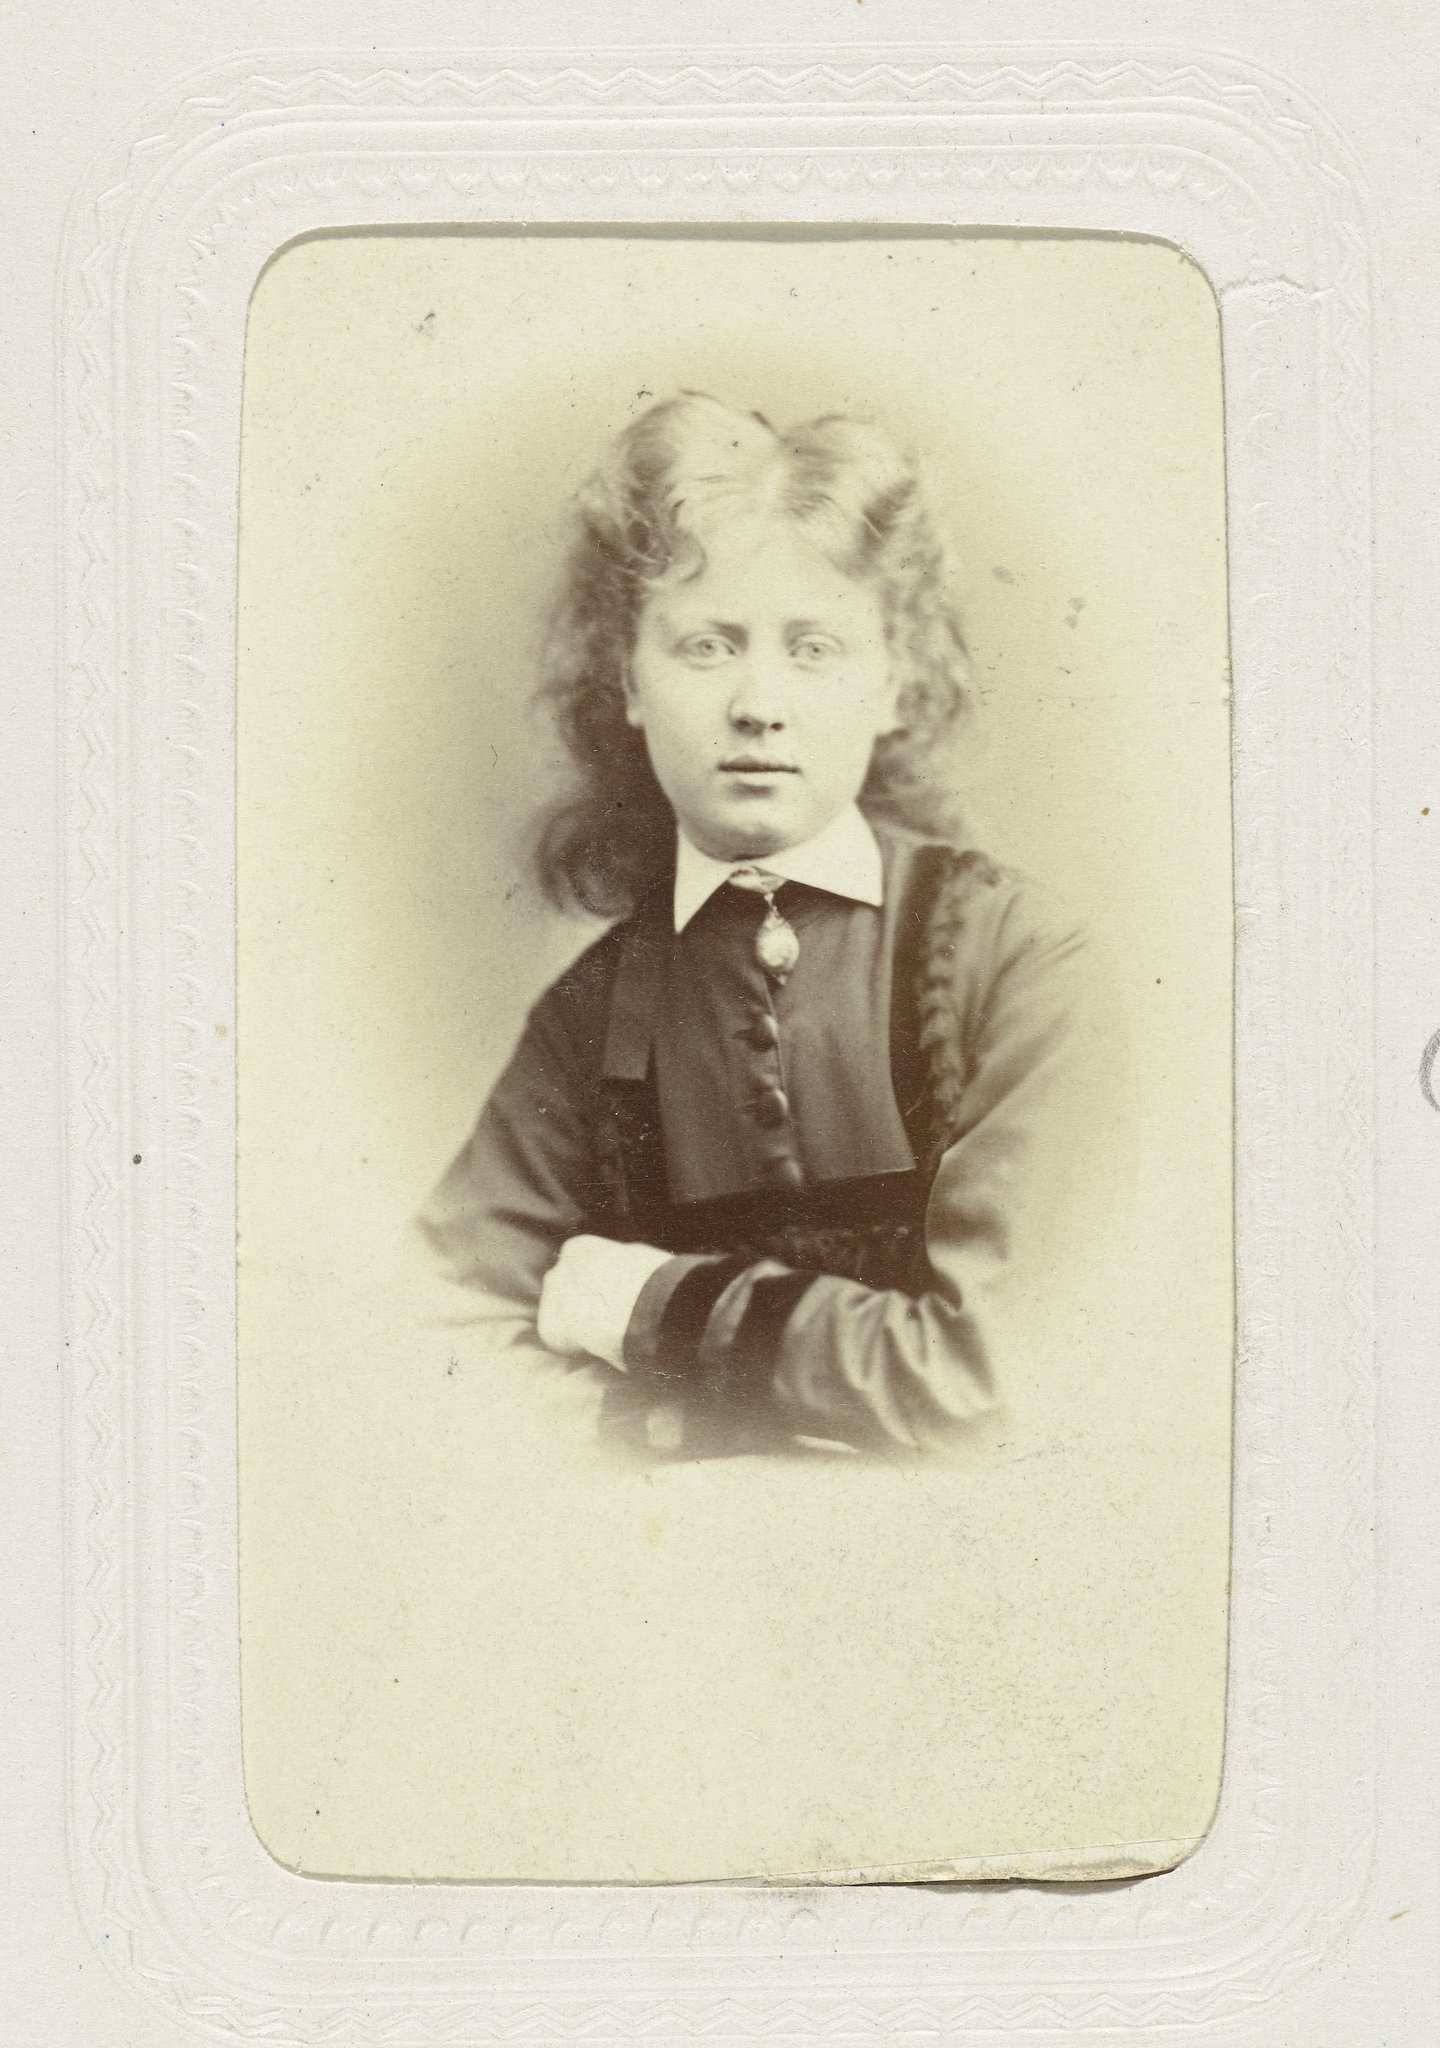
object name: carte de visite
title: Studioportret van een vrouw met golvend haar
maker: albert greiner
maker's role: fotograaf, fotostudio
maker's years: 1833-1890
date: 1863-1866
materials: cardboard, paper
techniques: albumen print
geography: amsterdam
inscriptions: name: ‘A. Greiner, Amsterdam’